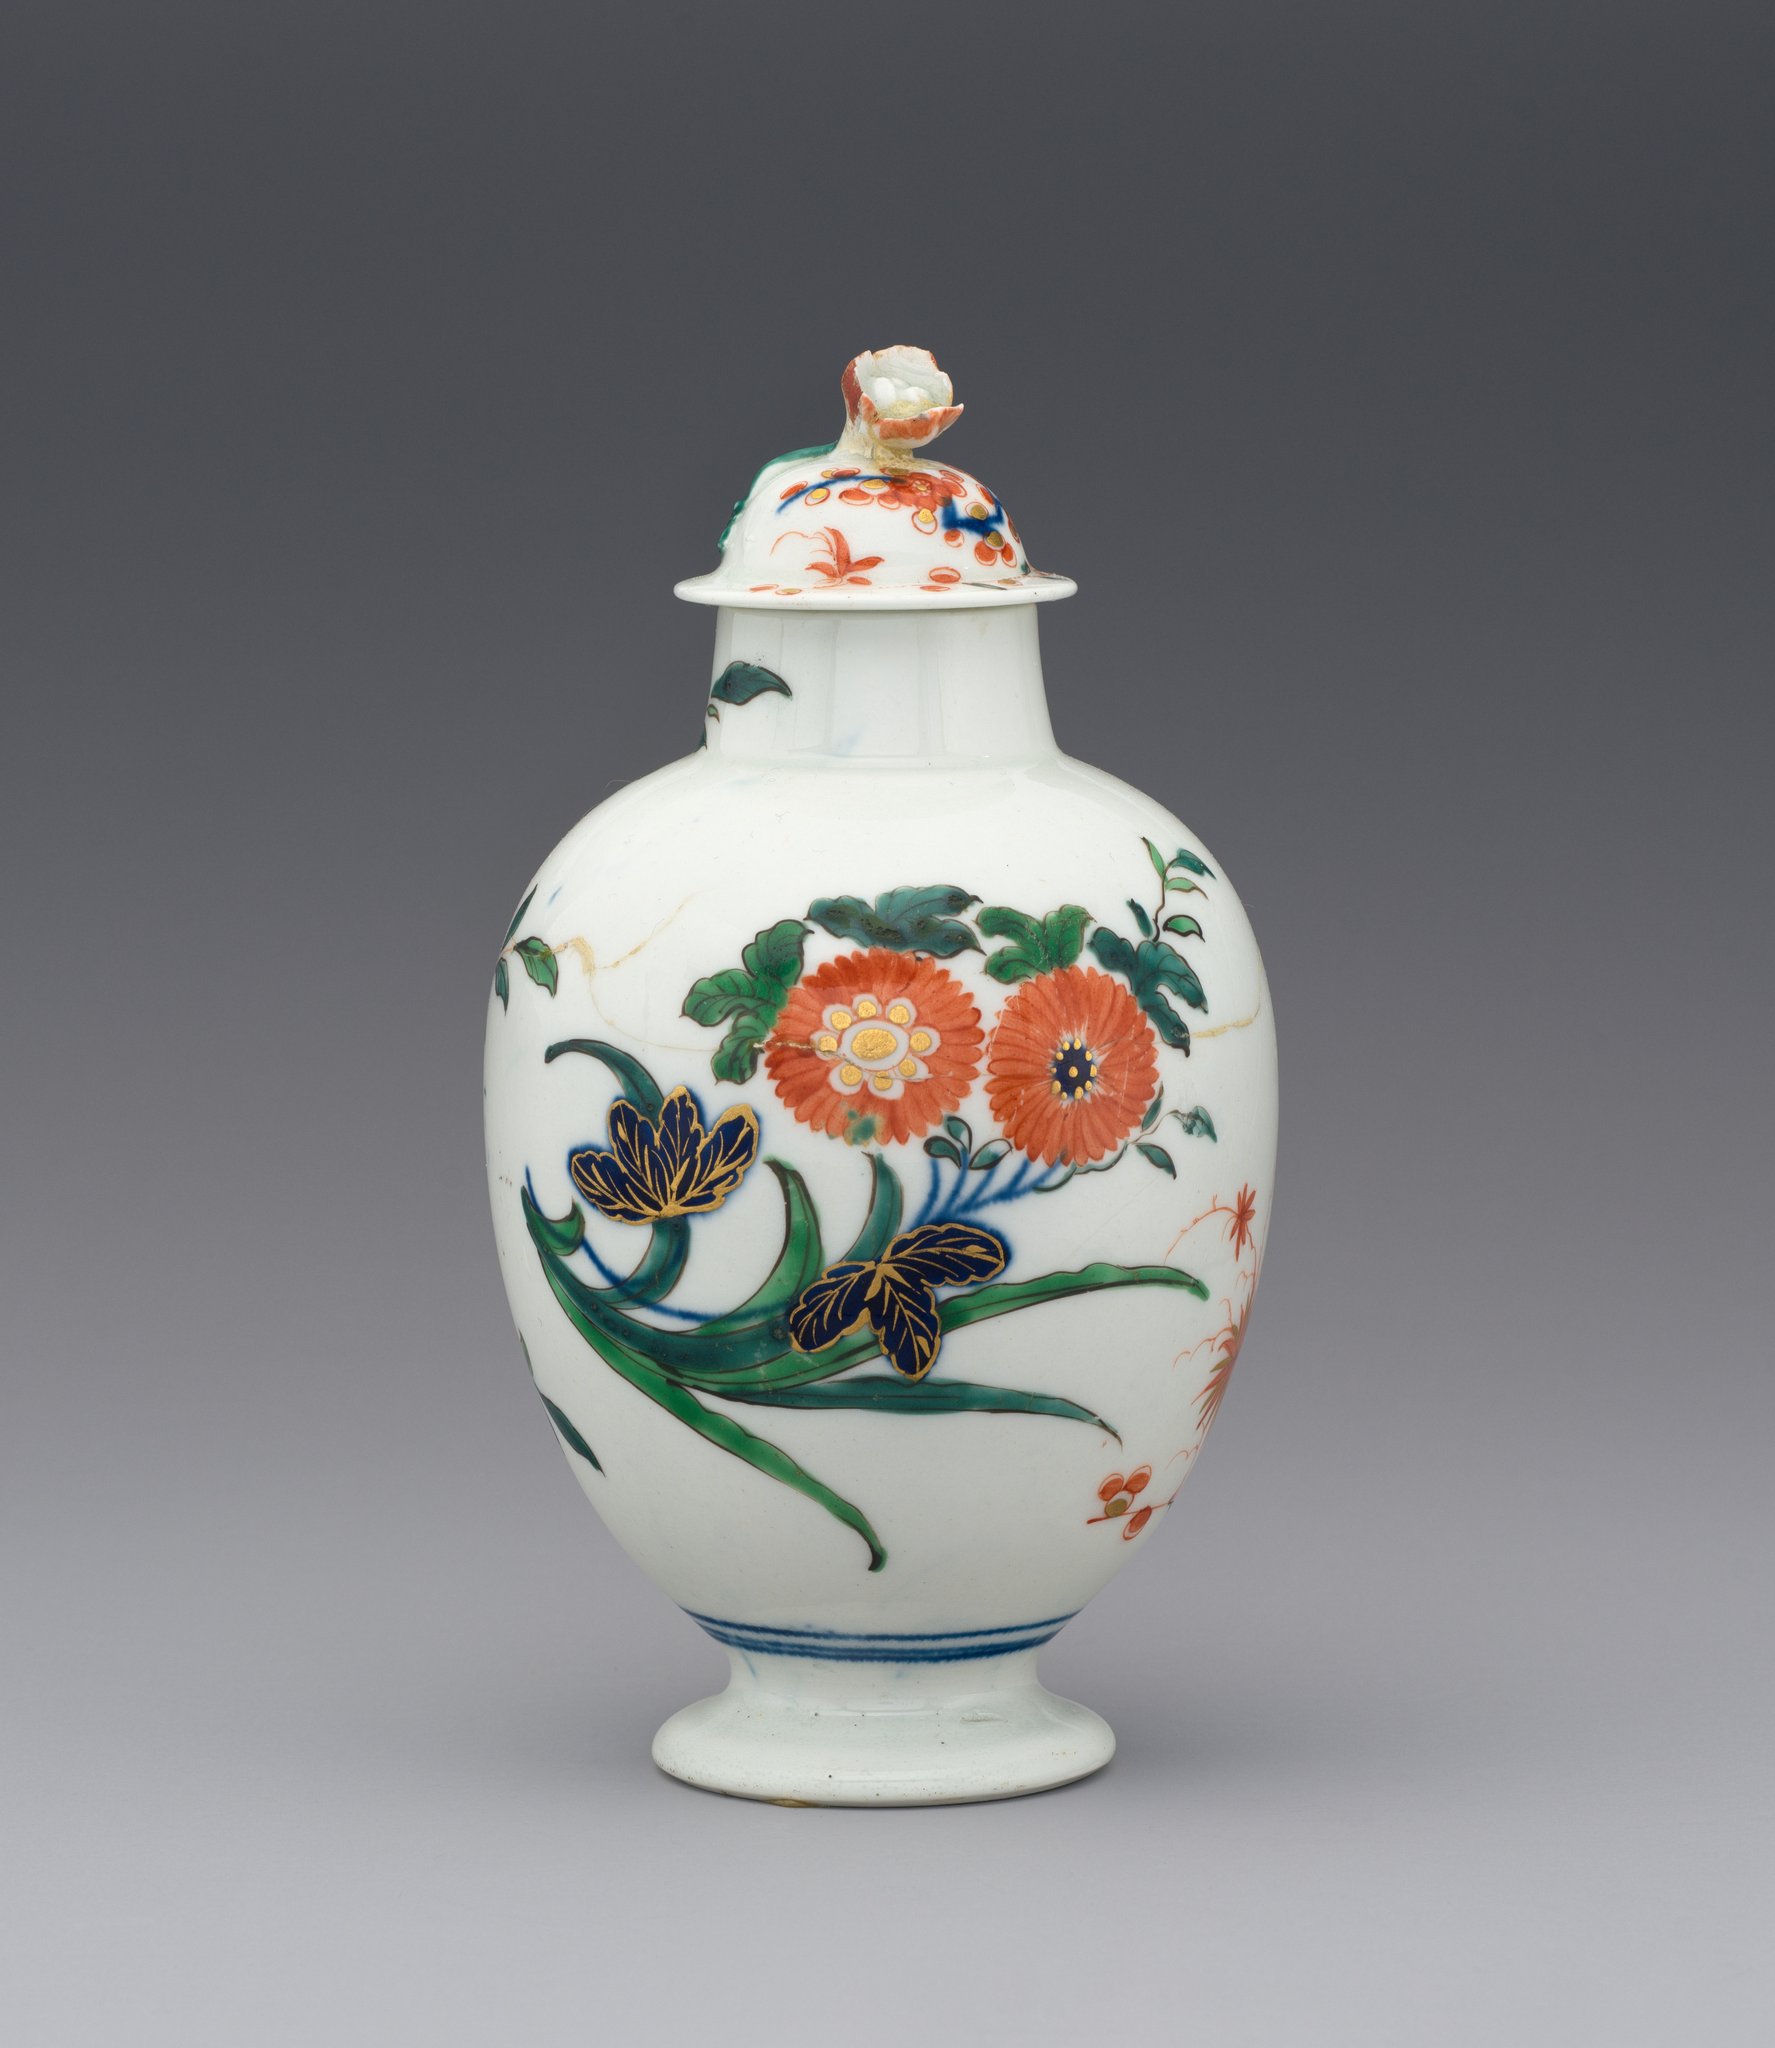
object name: tea caddy with cover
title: Tea caddy with cover (part of a service)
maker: worcester factory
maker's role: factory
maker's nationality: british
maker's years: 1751-2008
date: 1765-1770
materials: soft paste porcelain